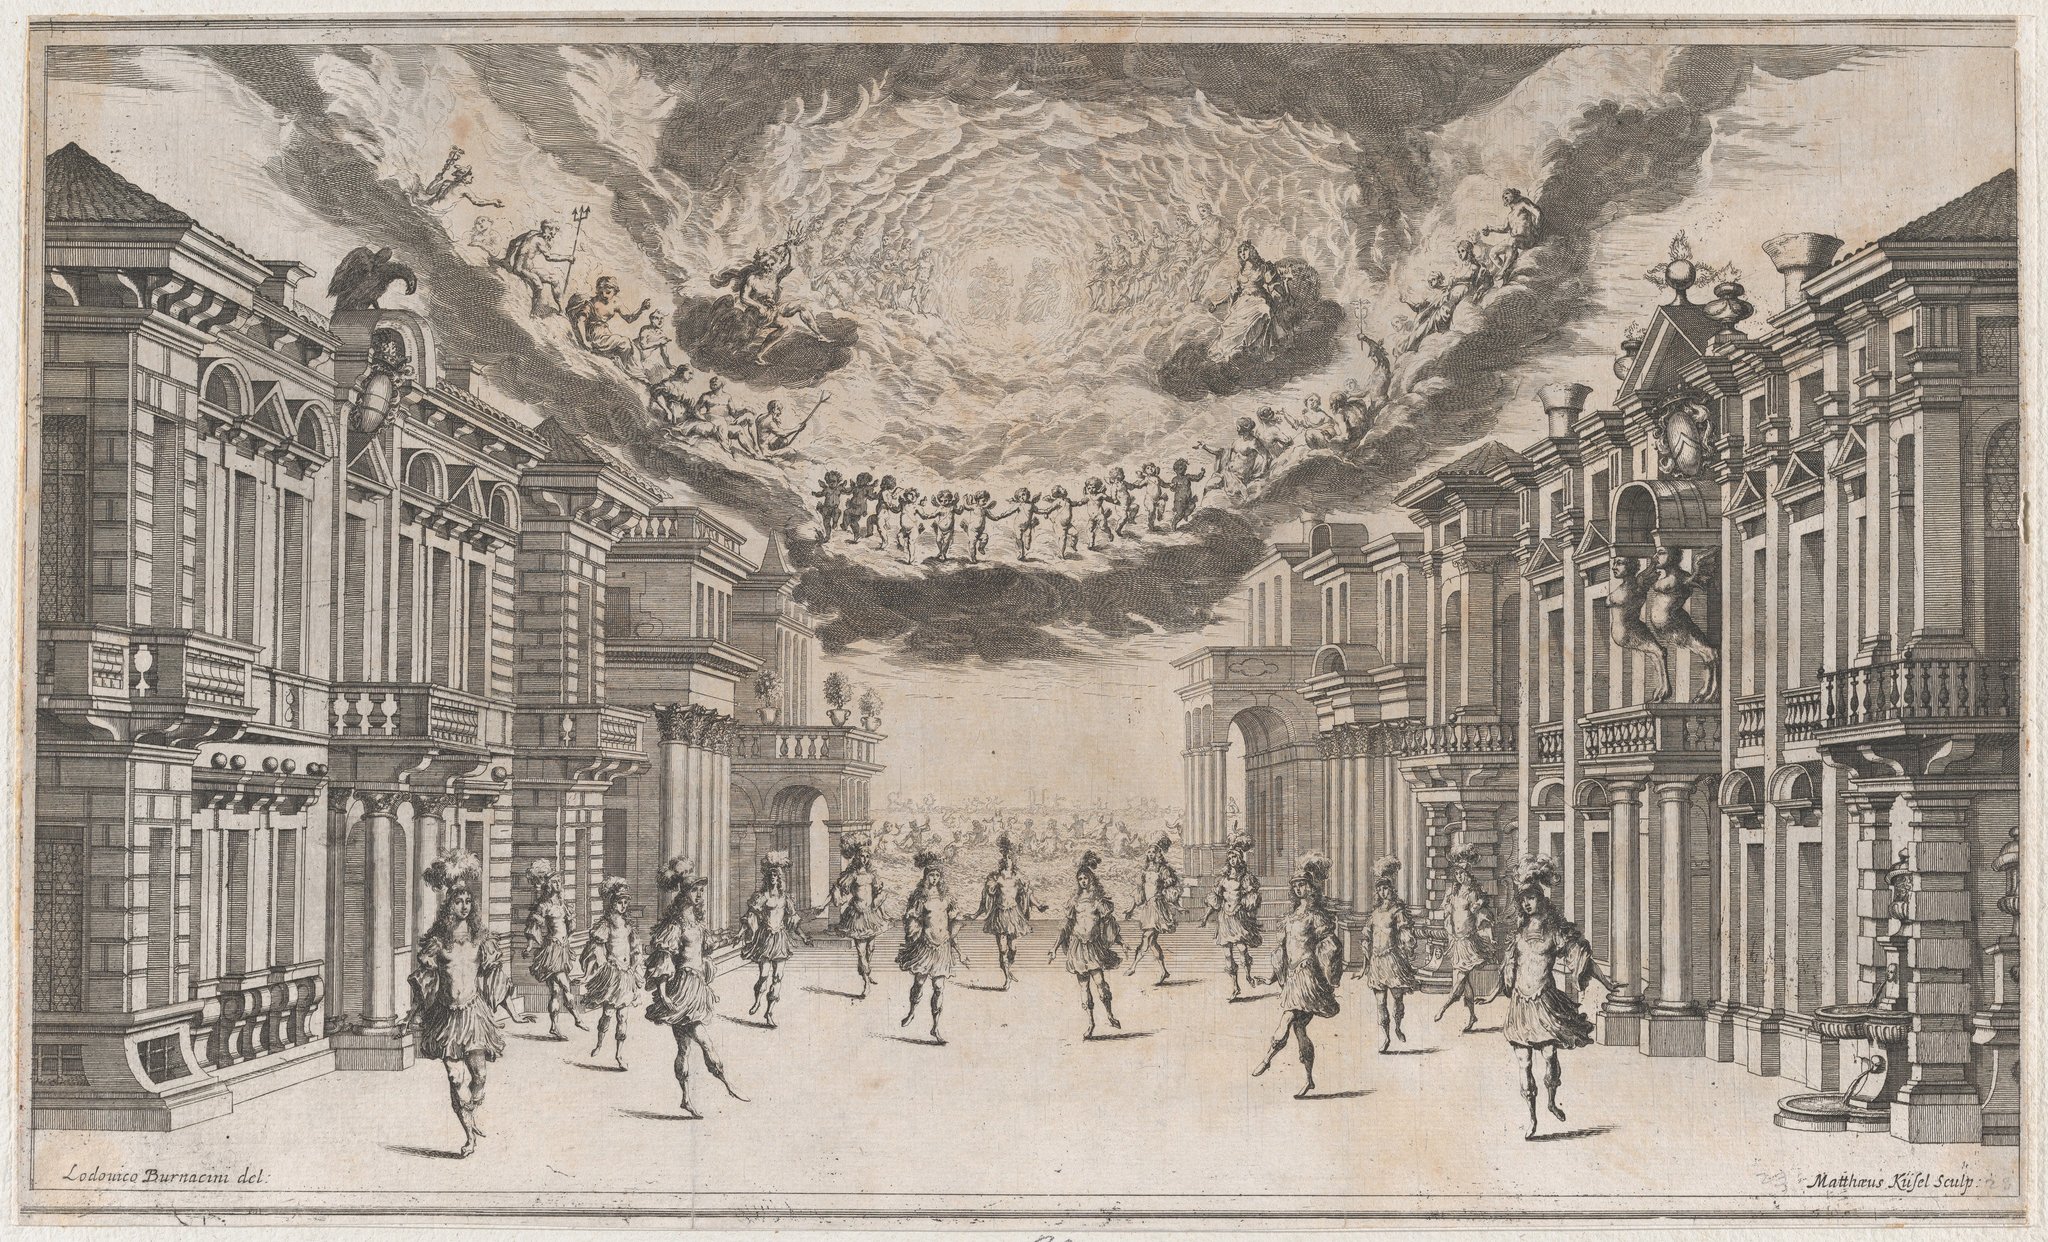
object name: print, fete, ornament architecture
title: A group of young men dancing as the gods look on from above; set design from 'Il Pomo D'Oro'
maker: mathäus küsel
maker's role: artist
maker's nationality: german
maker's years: 1621-1682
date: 1668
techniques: etching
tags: men,dancing